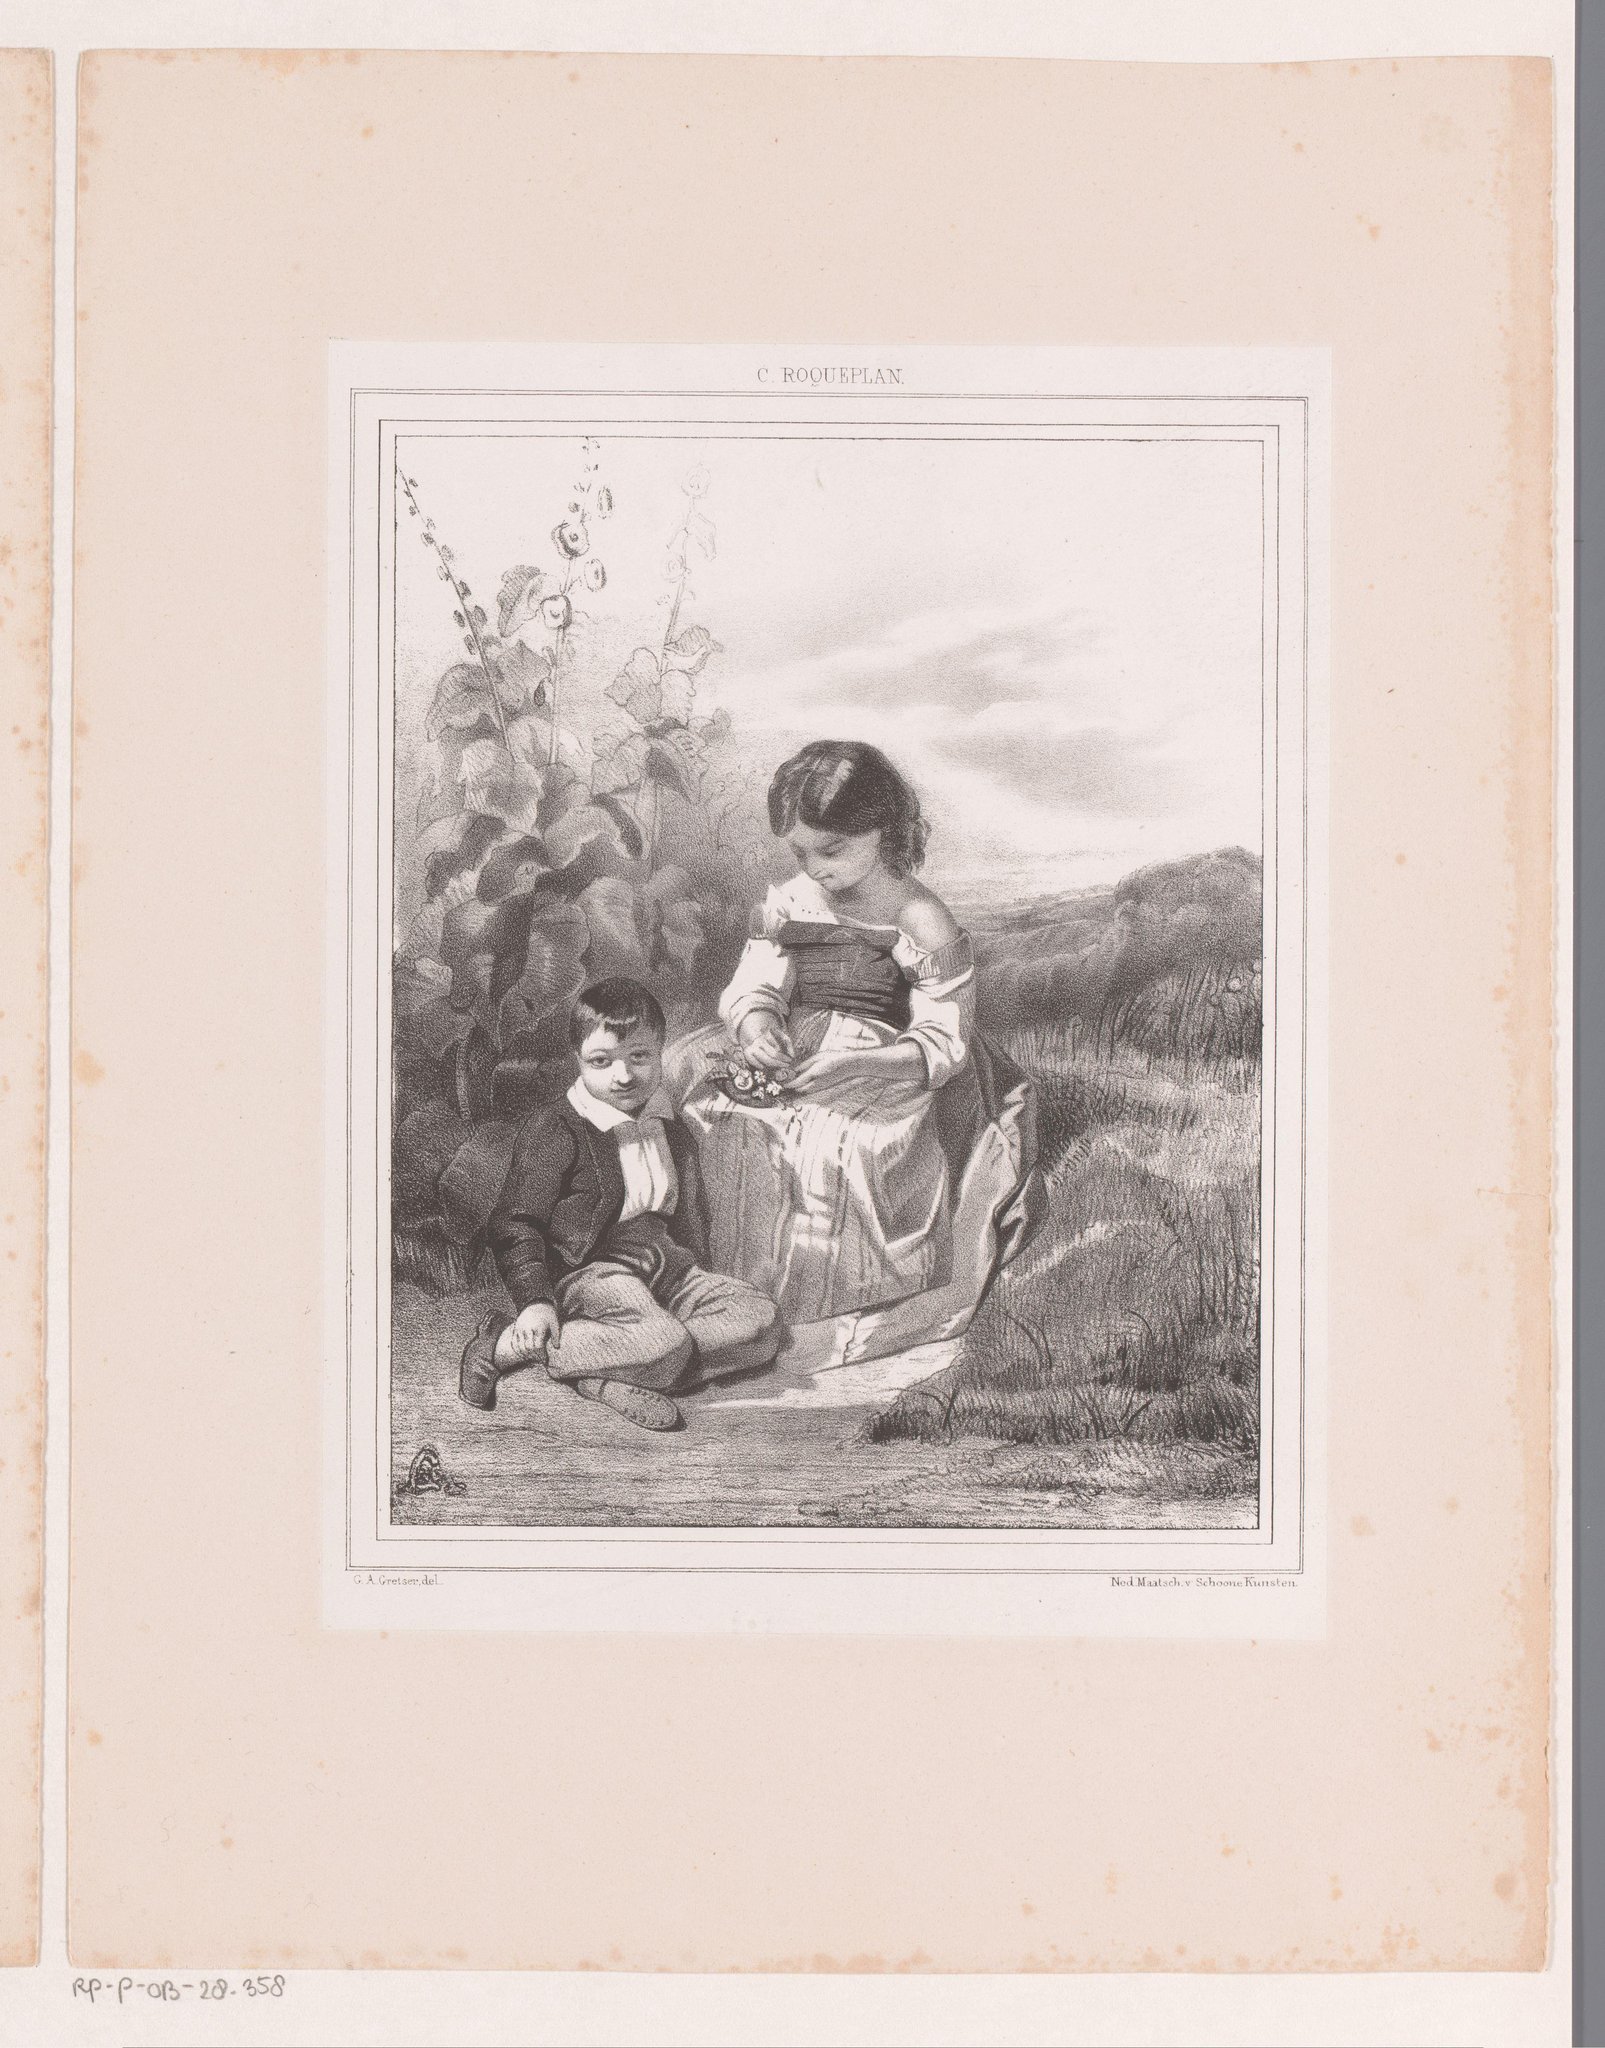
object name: print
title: Jongen en meisje in een tuin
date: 1825-1864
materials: paper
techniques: lithograph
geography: netherlands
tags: cut flowers; nosegay, bunch of flowers, boy (child between toddler and youth), garden, girl (child between toddler and youth)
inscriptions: collector's mark: Lugt 2228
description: Het meisje kijkt naar de jongen die voor haar op de grond zit. Ze heeft bloemen in haar schoot.